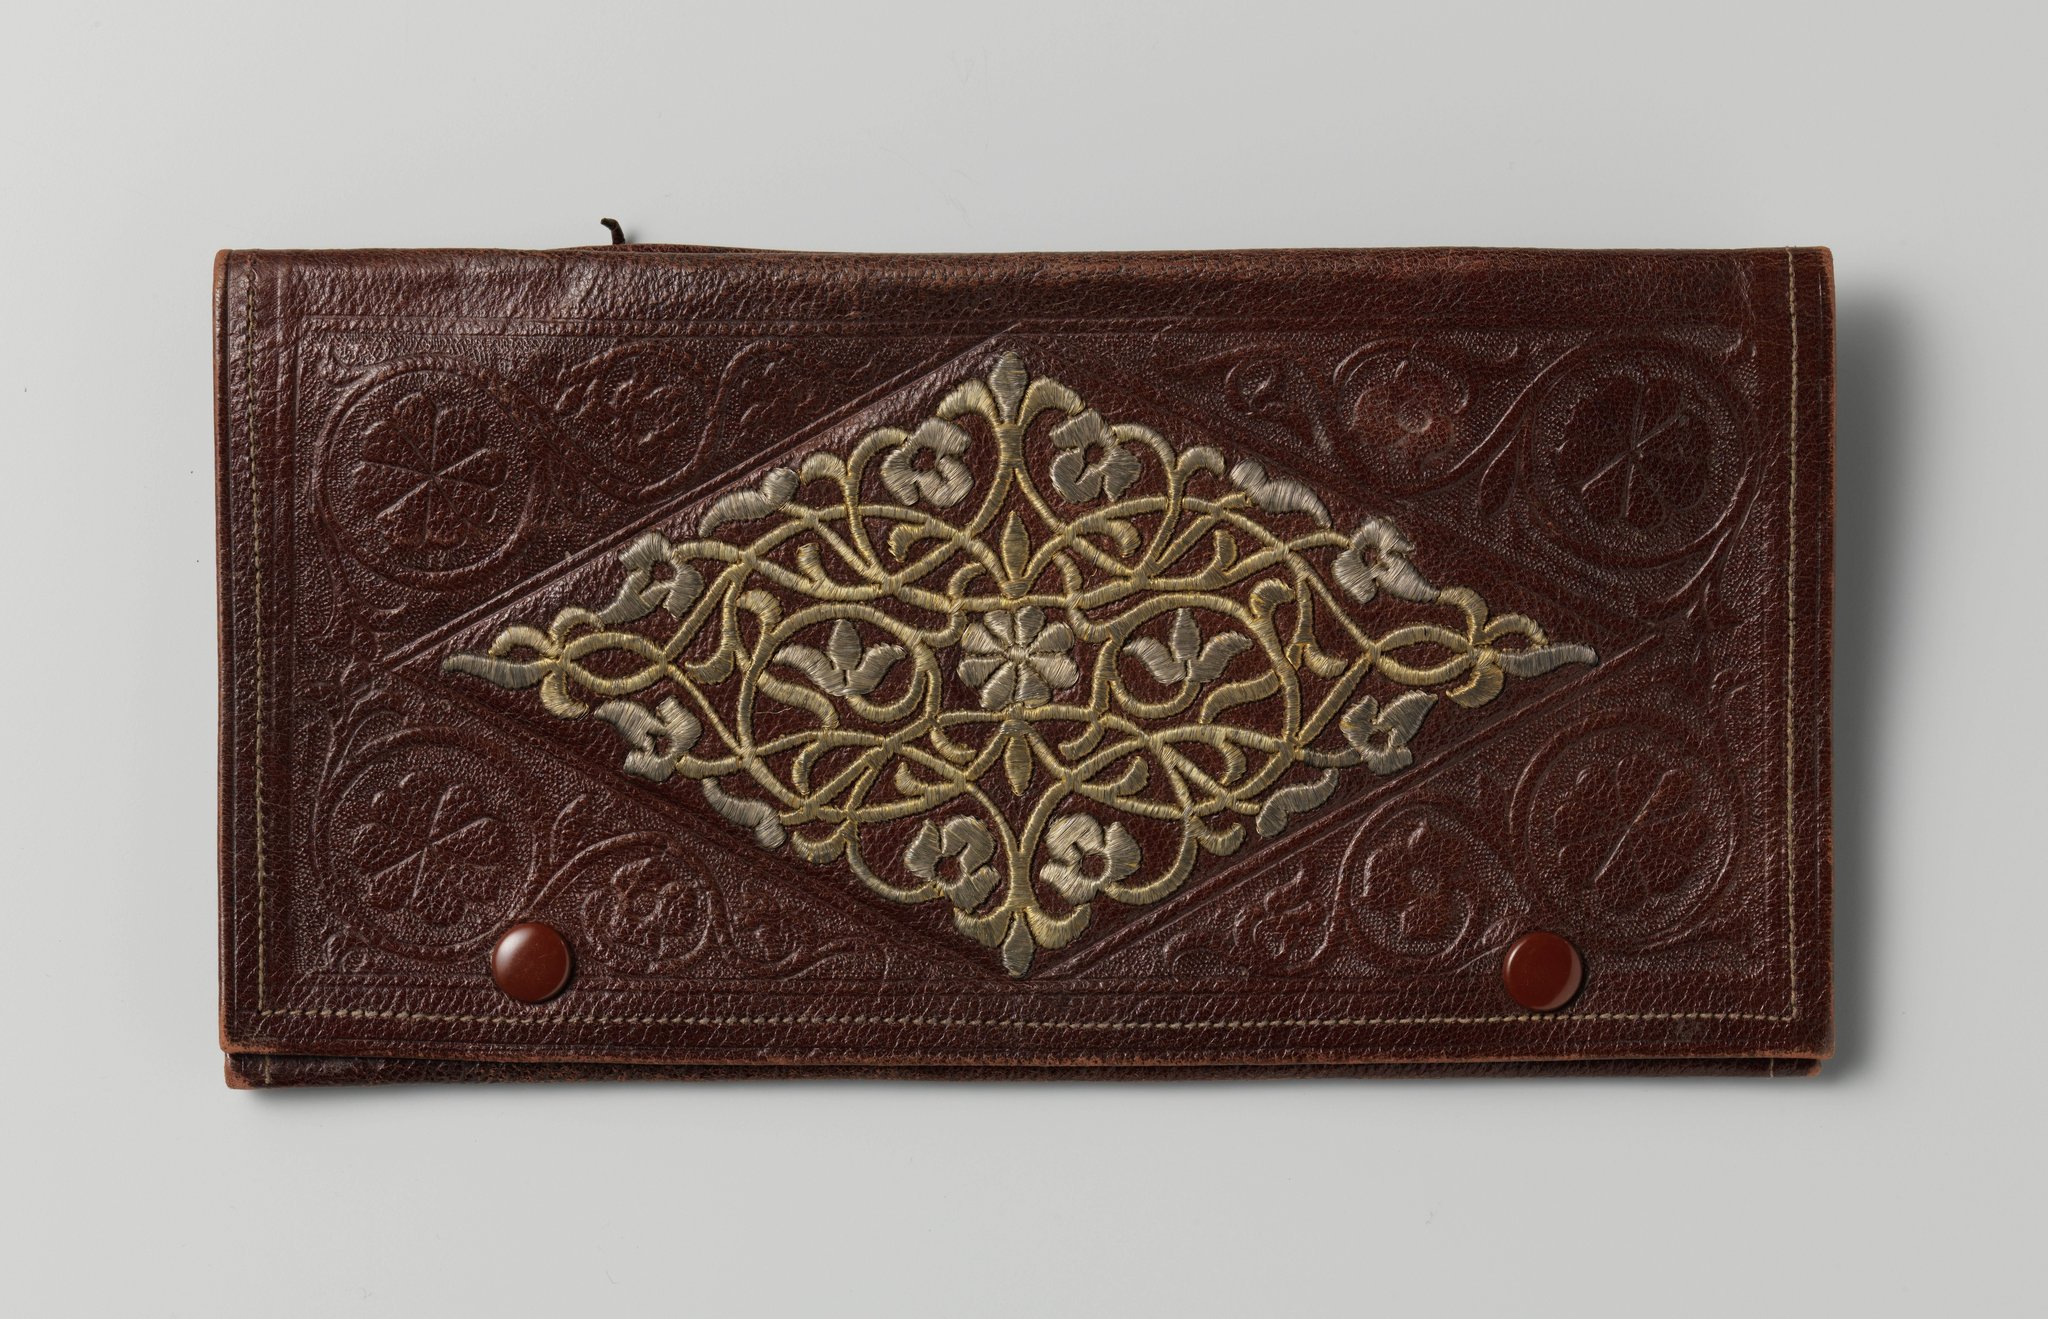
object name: brieventas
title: Brieventas in een plat, rechthoekig model, van donkerrood (kunst?)leer, waarop binnenin een ruitvorm een borduursel van gestileerde bloemen en takken in goud- en zilverdraad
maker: Anonymous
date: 1910-1915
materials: leather, thread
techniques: embroidered, tanning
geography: maghreb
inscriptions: : ‘'MADE IN FRANCE BC'’, initials: ‘'RG'’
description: Brieventas in een plat, rechthoekig model van donkerrood (kunst?)leer, waarop de klep binnenin een ruitvorm een borduursel van gestileerde bloemen en takken in goud- en zilverdraad. Rondom het ruit een patroon in reliëf in het leer gedrukt. Op de voorkant twee donkerrode drukknopen. De tas is met zwart leer gevoerd en heeft één soufflé. In het voorblad twee platte vlakken, gevoerd met suède, afgesloten met een klep die in een punt loopt. Aan de achterkant twee koperen ringen, met leer omkleed, waardoor een kort leren hengsel met twee drukknopen. Onderop deze drukknopen staat 'made in France'. Middenop het achterpand een horizontale band van leer.